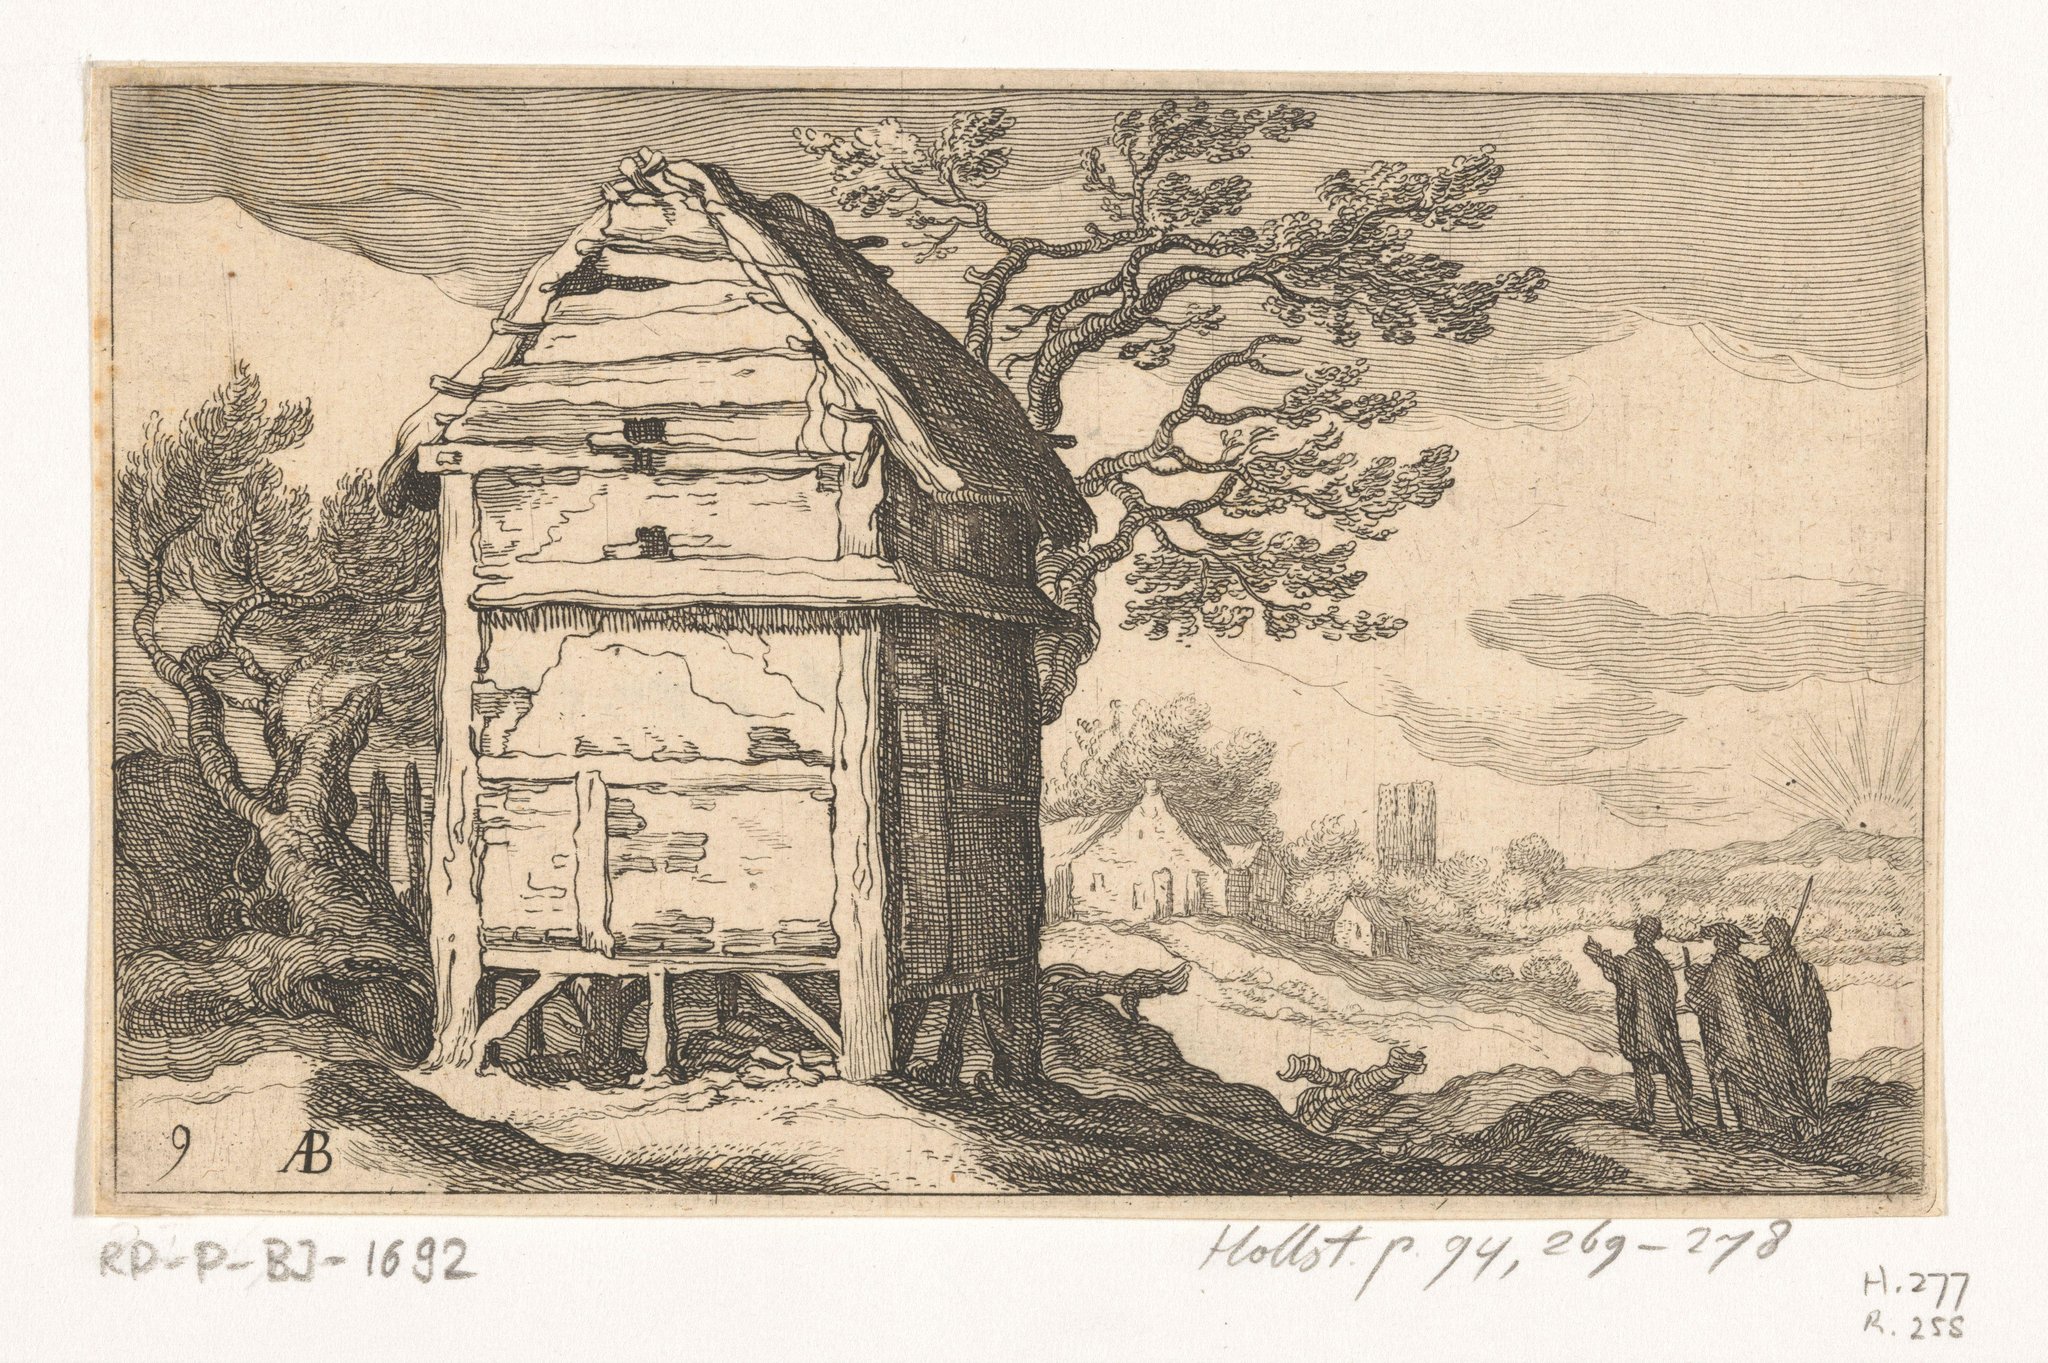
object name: print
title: Kleine landschappen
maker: frederick bloemaert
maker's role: print maker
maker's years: 1614-1669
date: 1635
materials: paper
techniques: engraving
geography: utrecht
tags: landscapes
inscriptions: collector's mark: Lugt 240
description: Links op de voorgrond een hoge schuur voor wat bomen. Rechts drie reizigers en een lage zon.